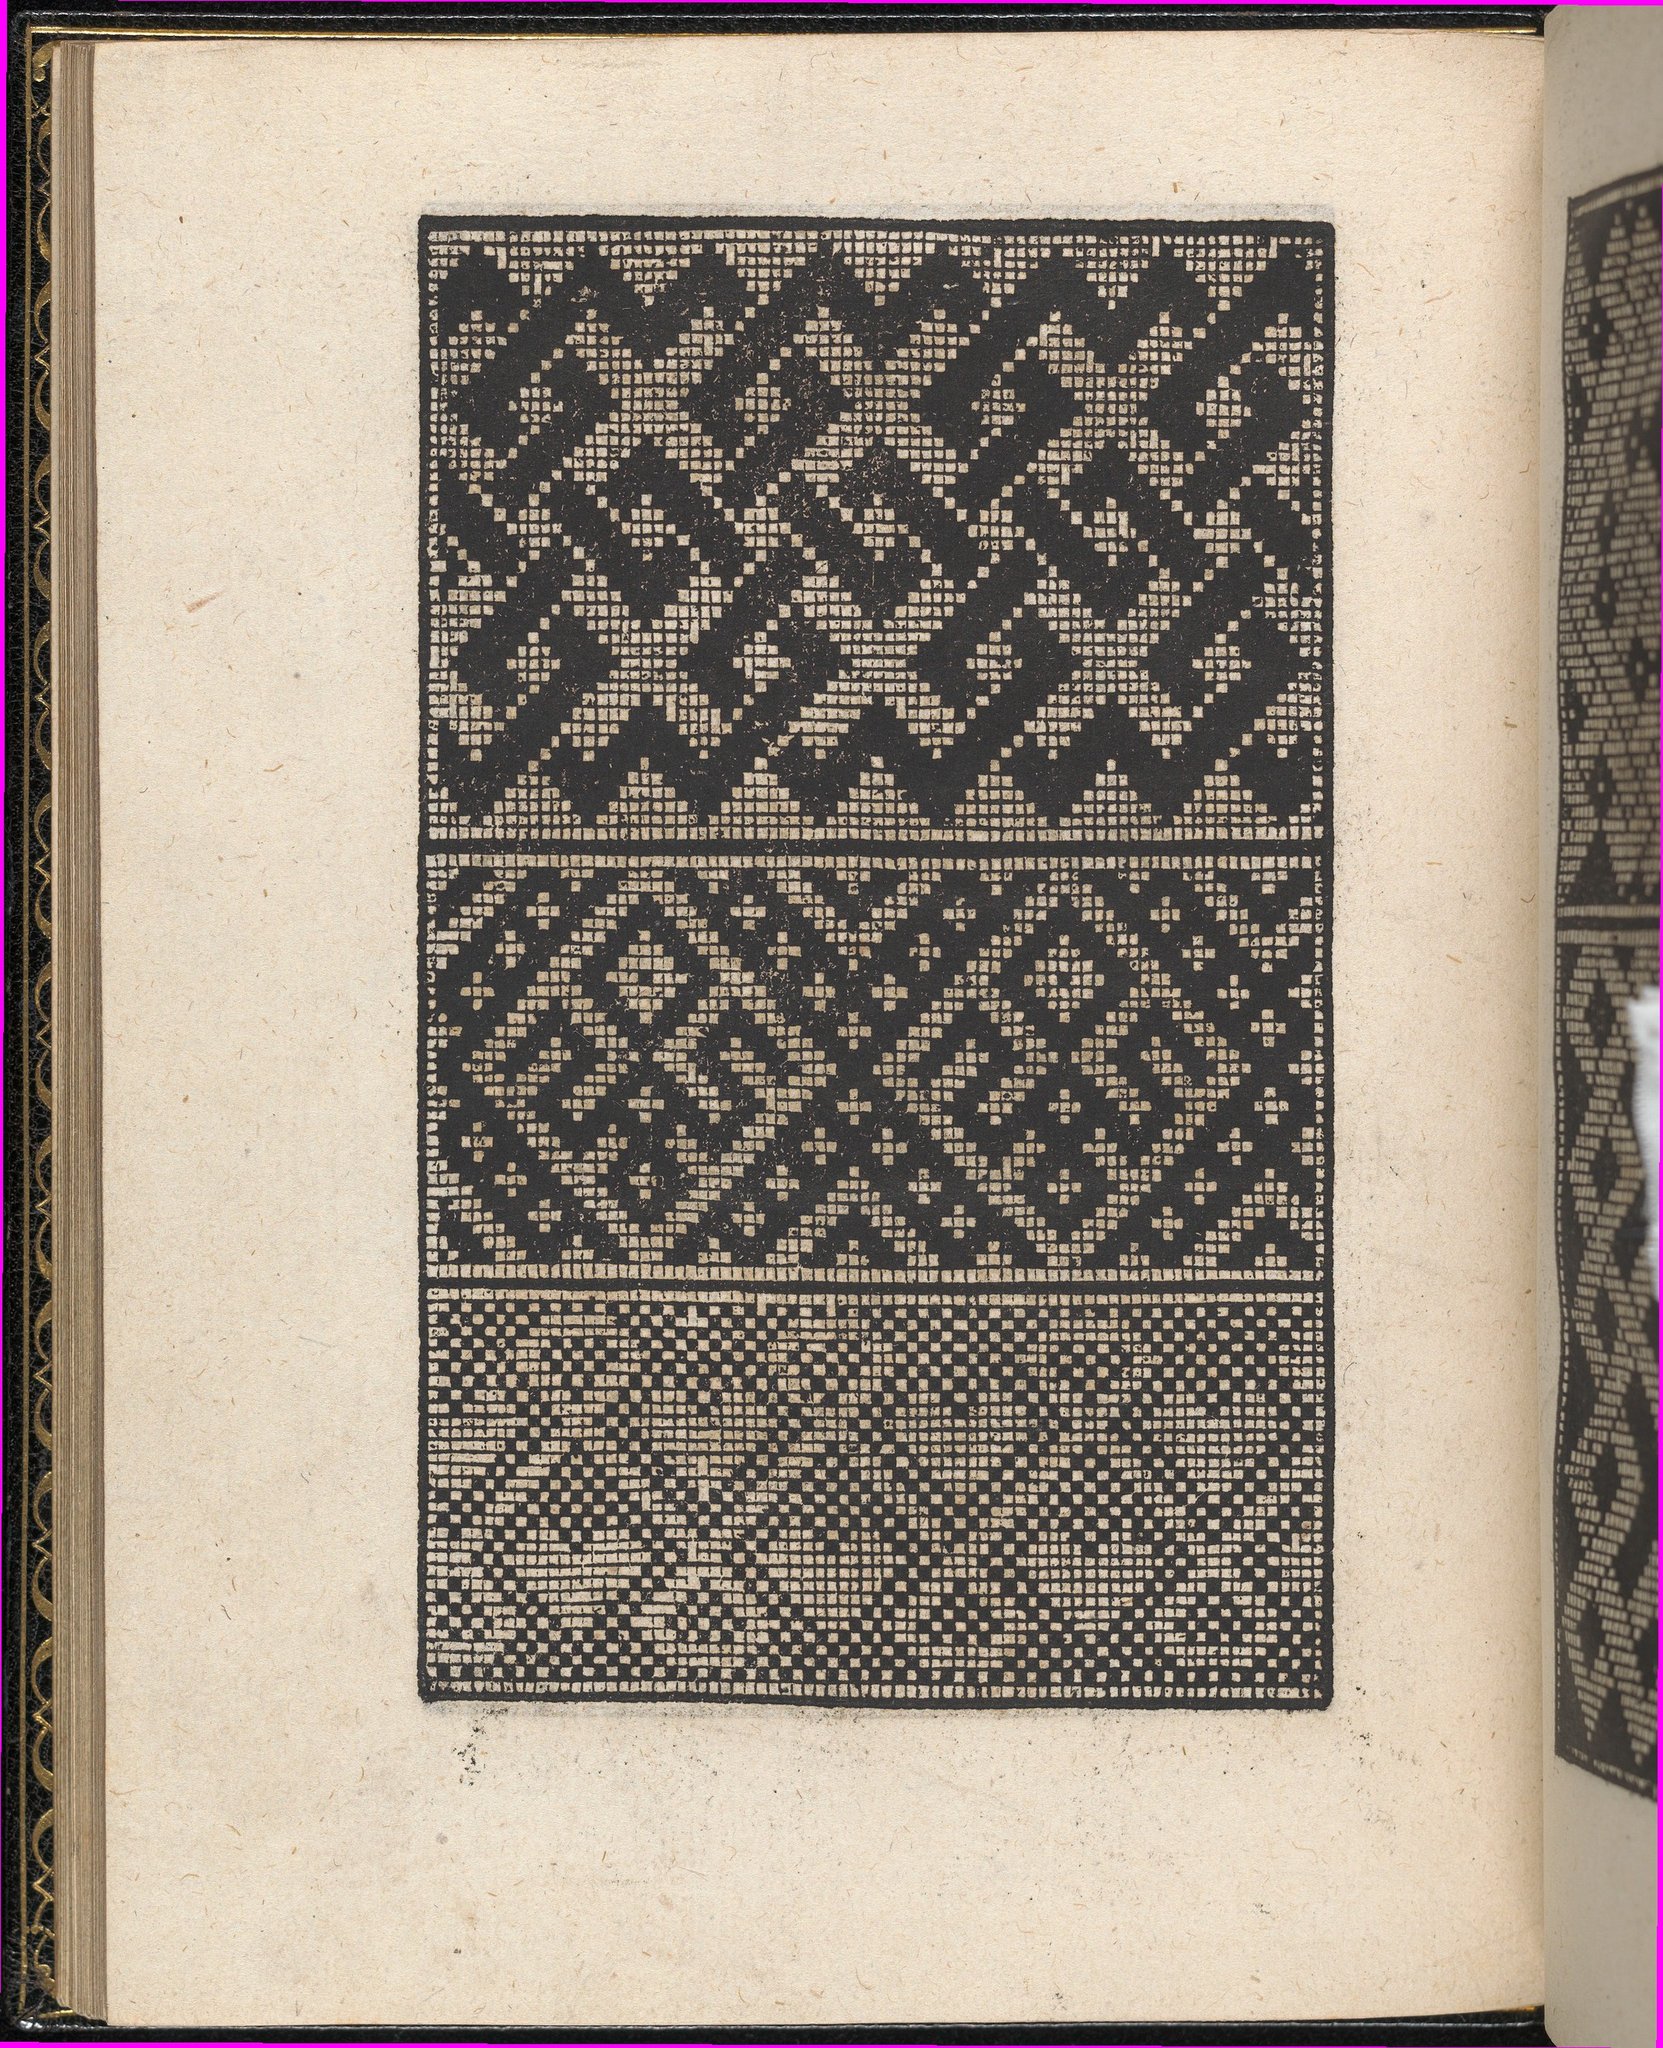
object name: book print ornament architecture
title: Page from Ein new kunstlich Modelbuch...(Page 34v)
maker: peter quentel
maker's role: publisher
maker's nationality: german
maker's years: 1500-1550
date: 1544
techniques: woodcut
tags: ornament